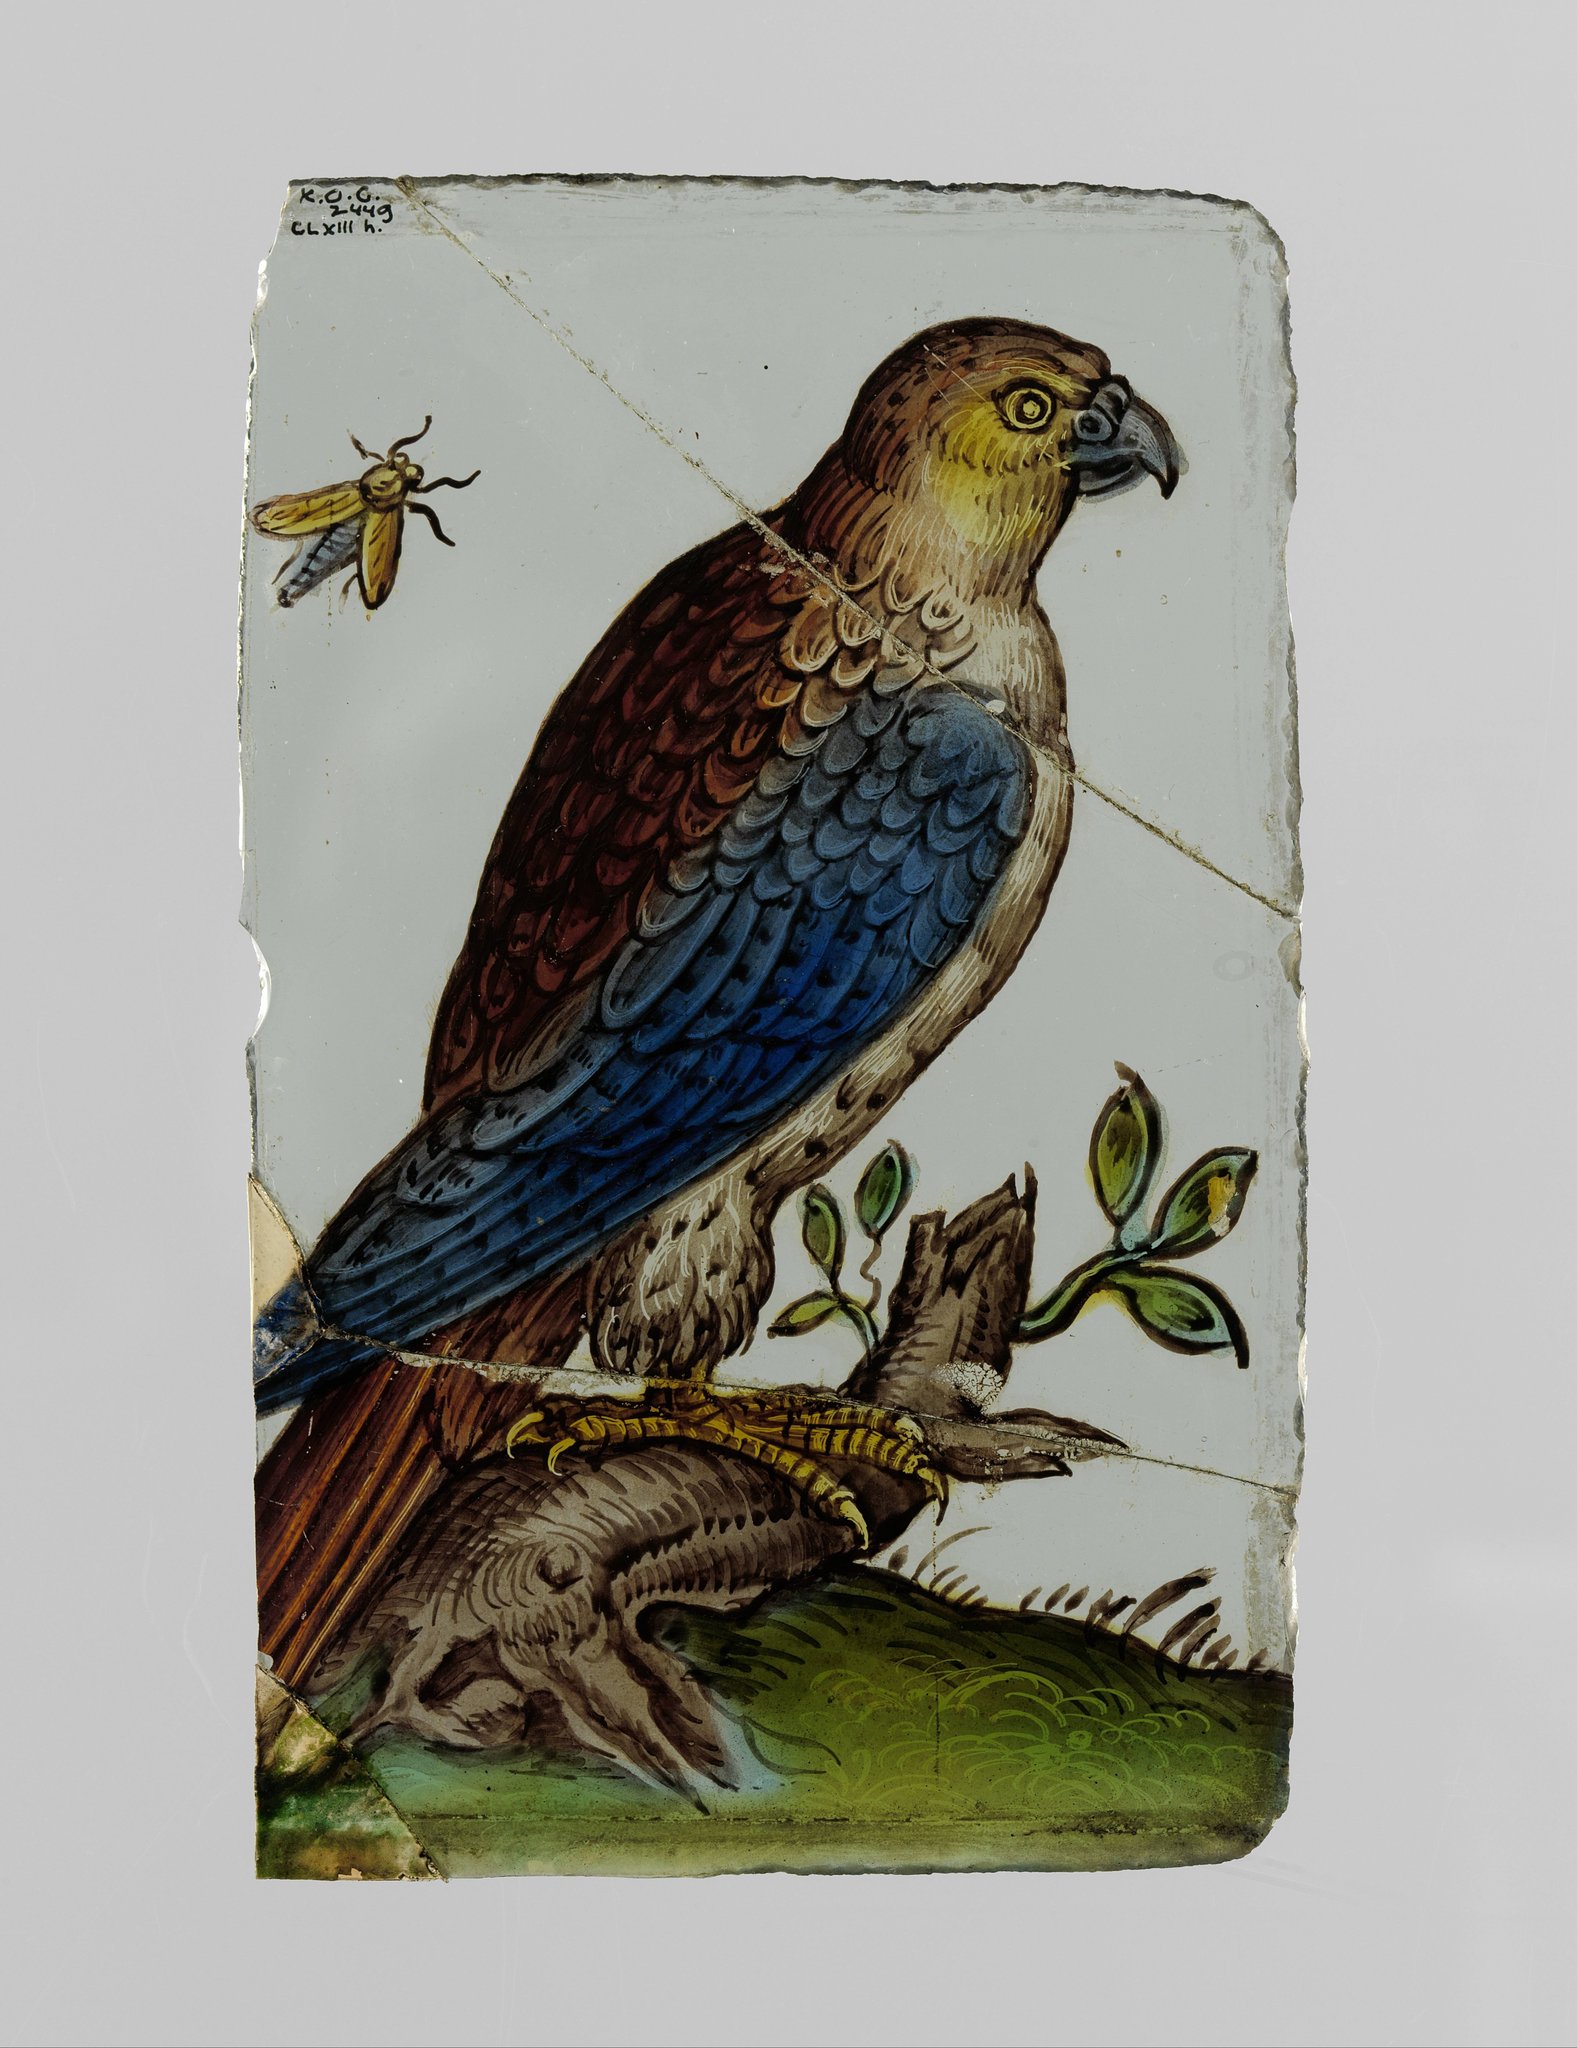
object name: light window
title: Ruit met havik op boomstronk en insekt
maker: Anonymous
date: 1650-1675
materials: glass, lead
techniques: leading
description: Ruitje met emailschildering van een vogel (havik) gezeten op een boomstronk en een insekt. Opmerking: Onderdeel van de groep BK-CLXIII-a t/m r.